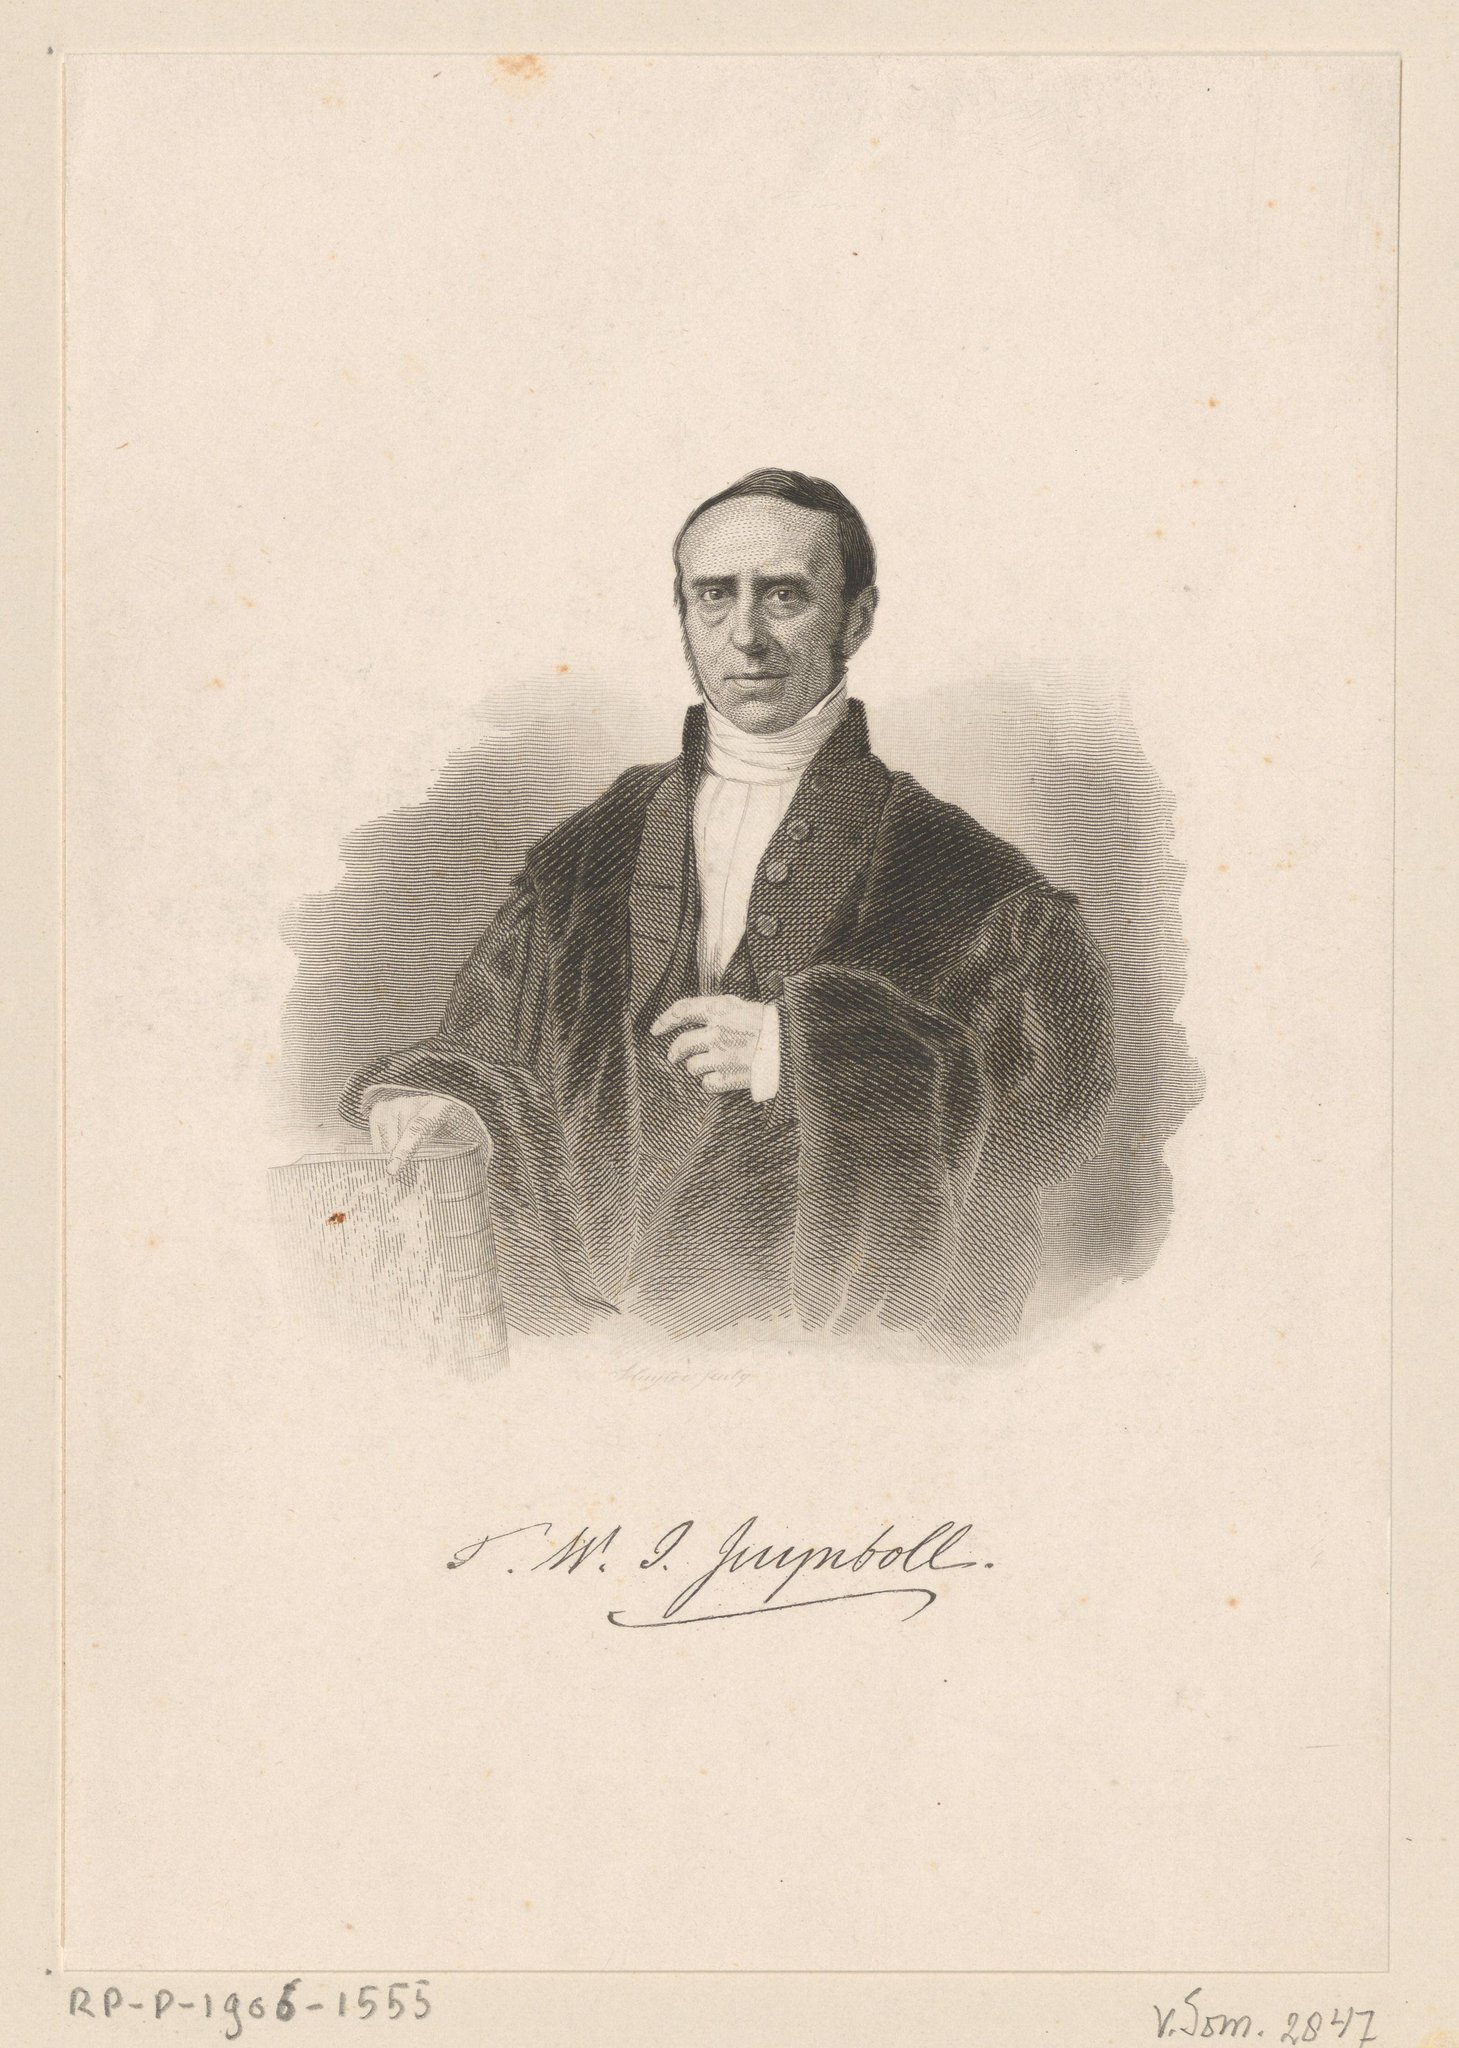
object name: print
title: Portret van Theodoor Willem Johannes Juynboll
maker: dirk jurriaan sluyter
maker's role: draughtsman, print maker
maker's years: 1811-1886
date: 1854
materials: paper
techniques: engraving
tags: rotterdam, leiden, historical persons, professor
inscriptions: collector's mark: Lugt 2228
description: Prent waarschijnlijk uit: Leidschen Studentenalmanak, 1854.